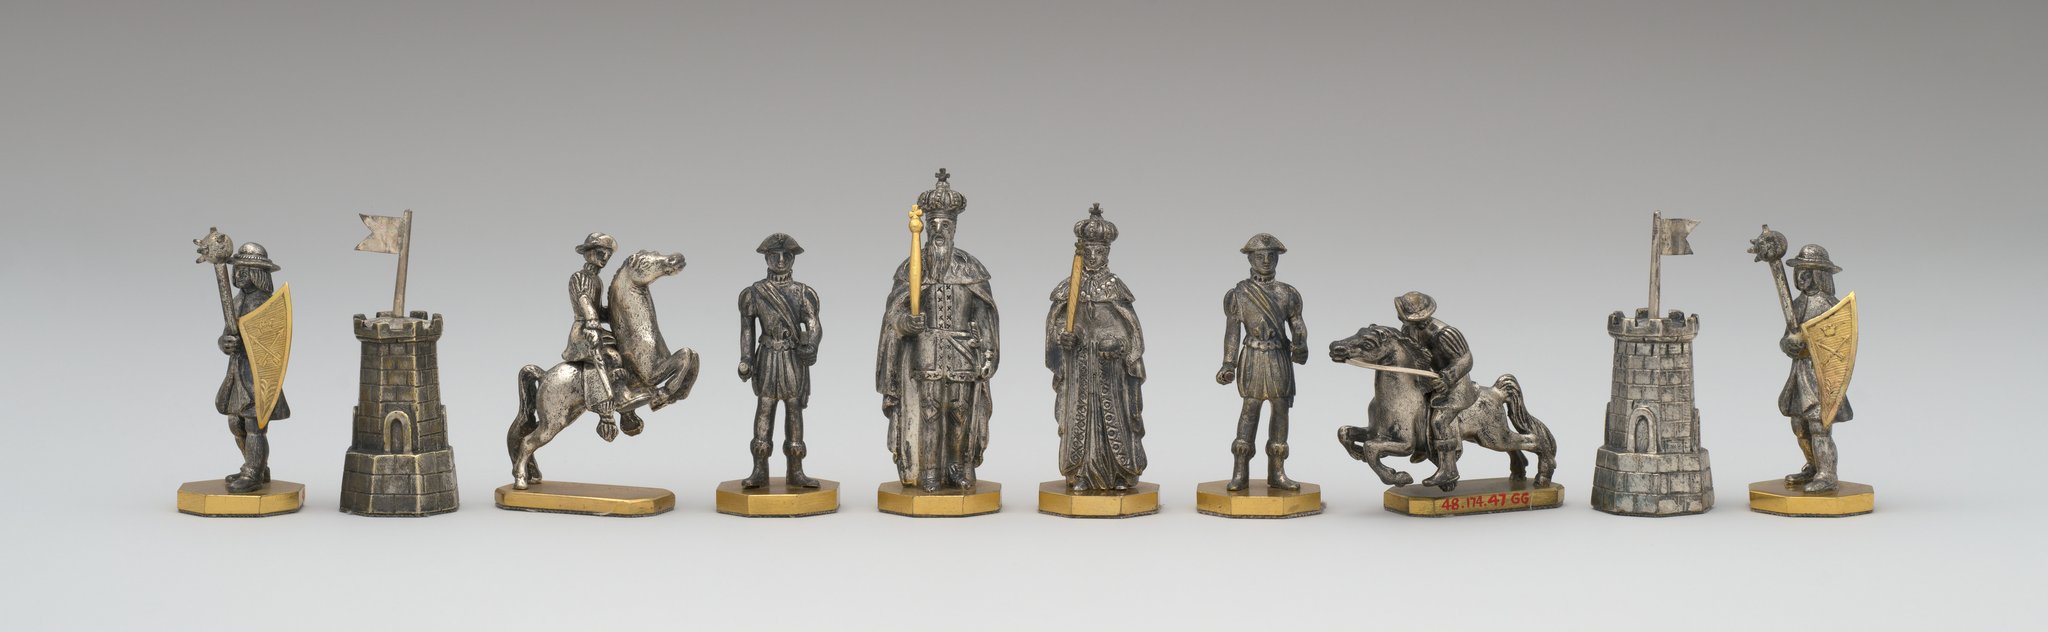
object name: chessman and board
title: Thirty Years War chessmen (32) and board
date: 1860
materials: brass, silver, silver gilt, wood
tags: chess